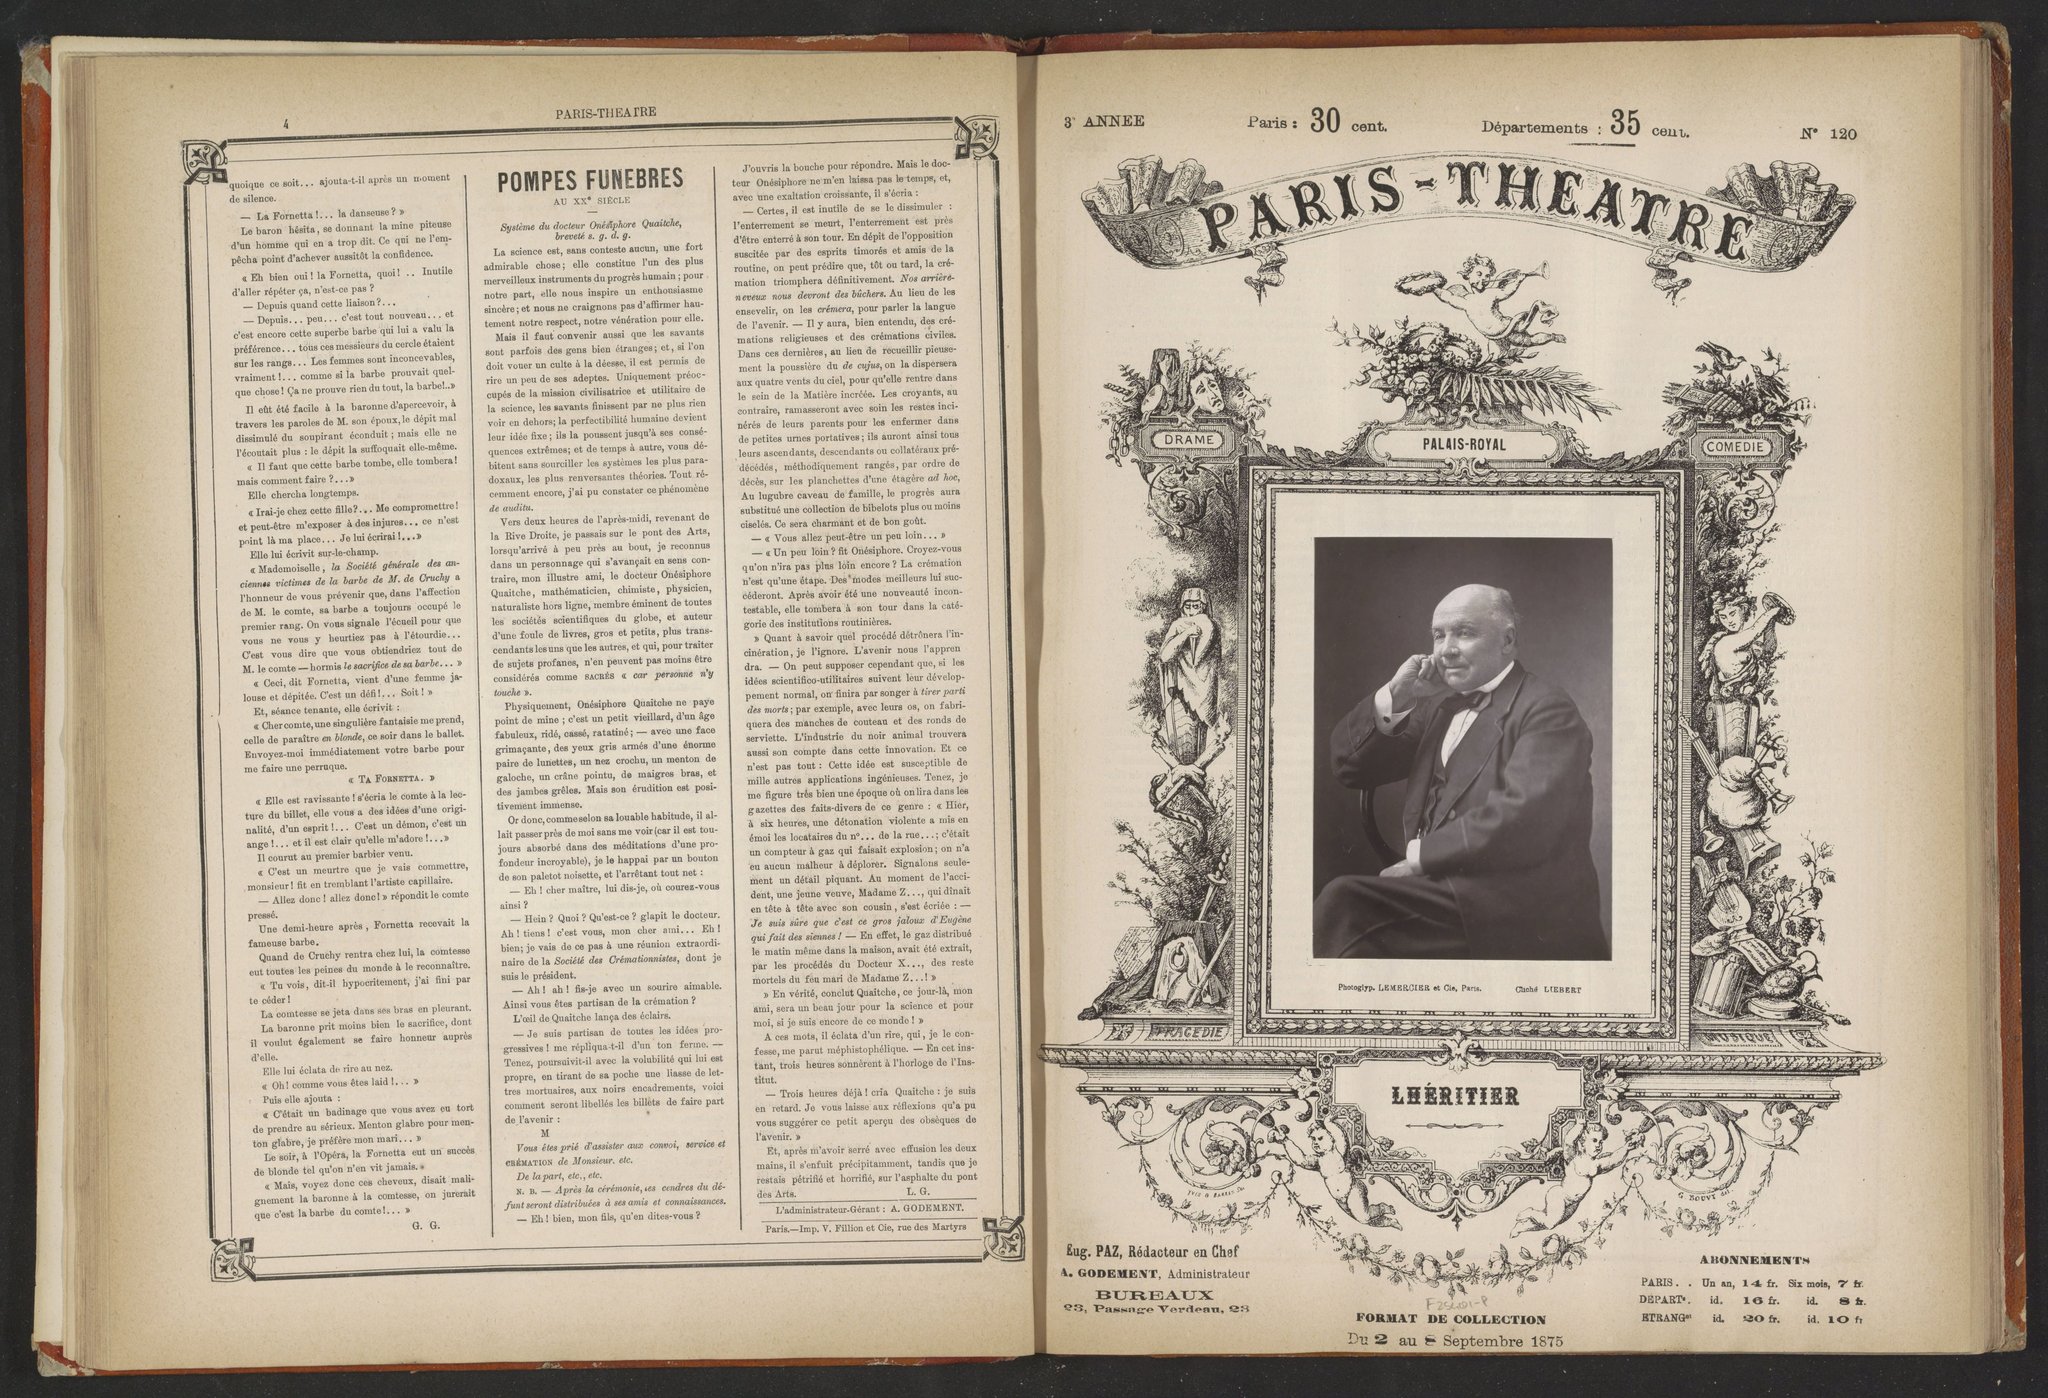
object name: photomechanical print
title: Portret van Lhéritier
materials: paper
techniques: woodburytype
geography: france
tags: portrait of actor, actress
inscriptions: number: ‘No 120’, inscription: ‘Du 2 au 8 Septembre 1875’